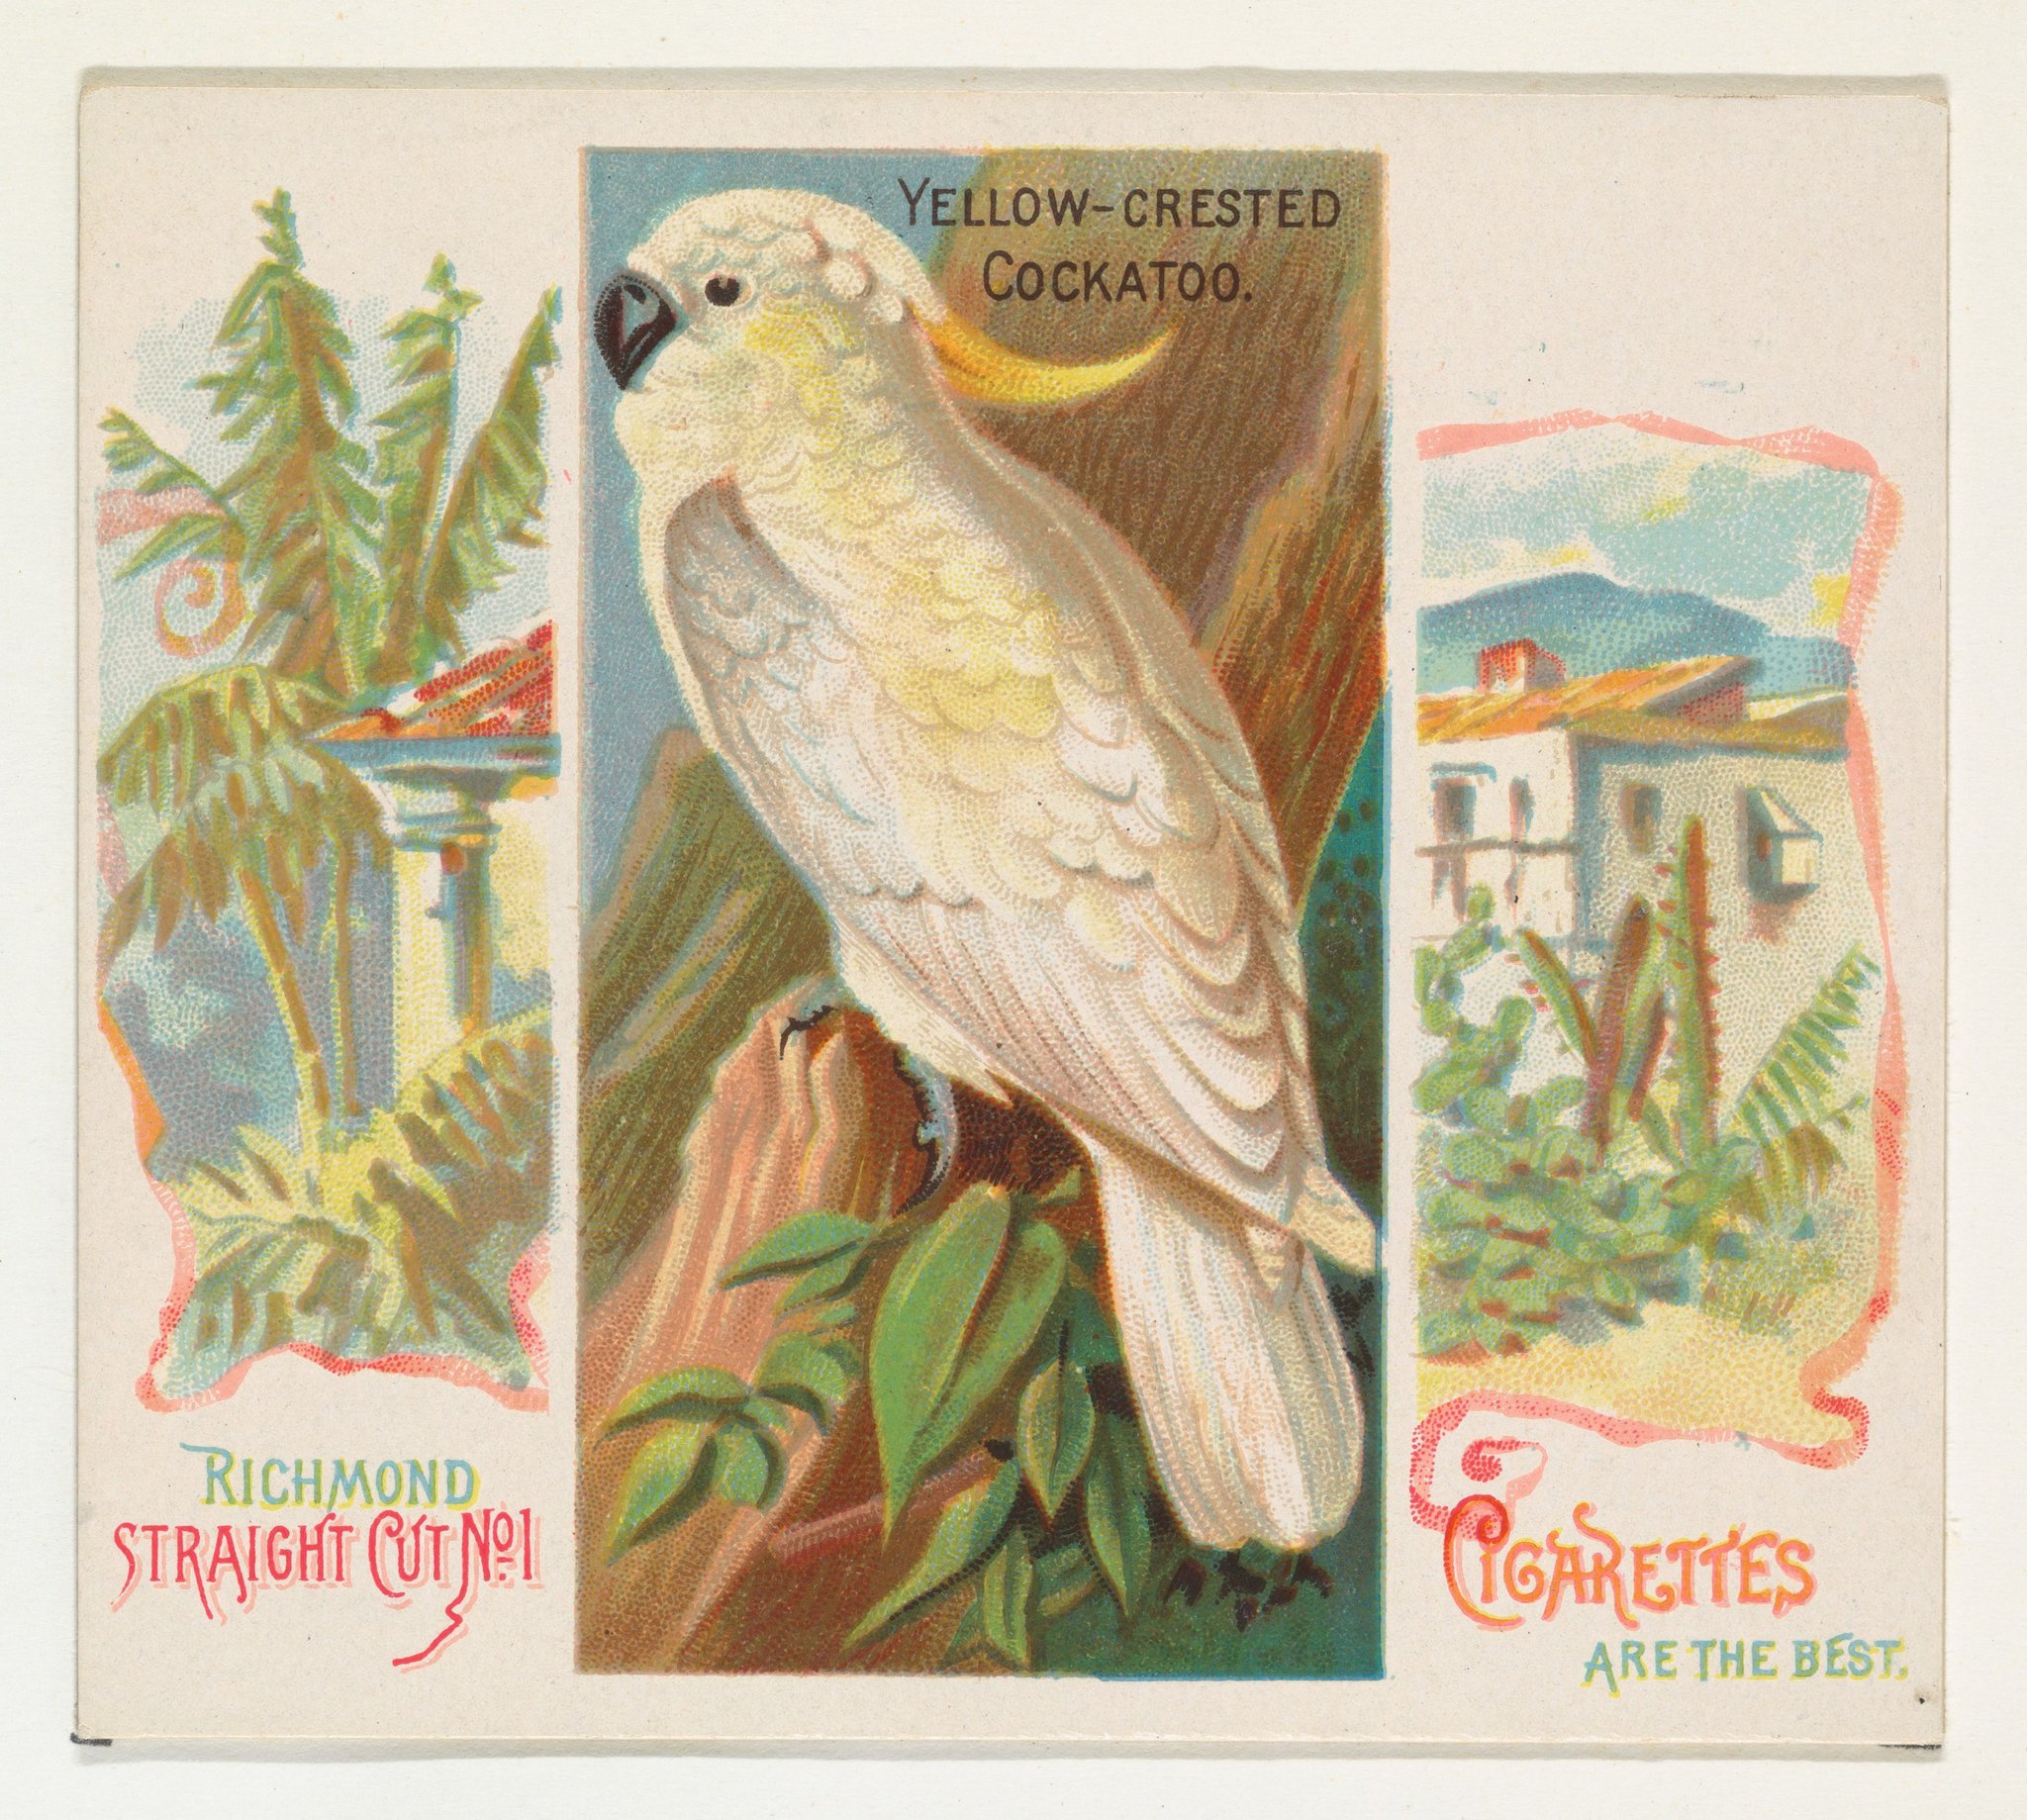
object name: print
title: Yellow-Crested Cockatoo, from Birds of the Tropics series (N38) for Allen & Ginter Cigarettes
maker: allen & ginter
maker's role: publisher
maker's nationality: american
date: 1889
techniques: color lithograph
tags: birds